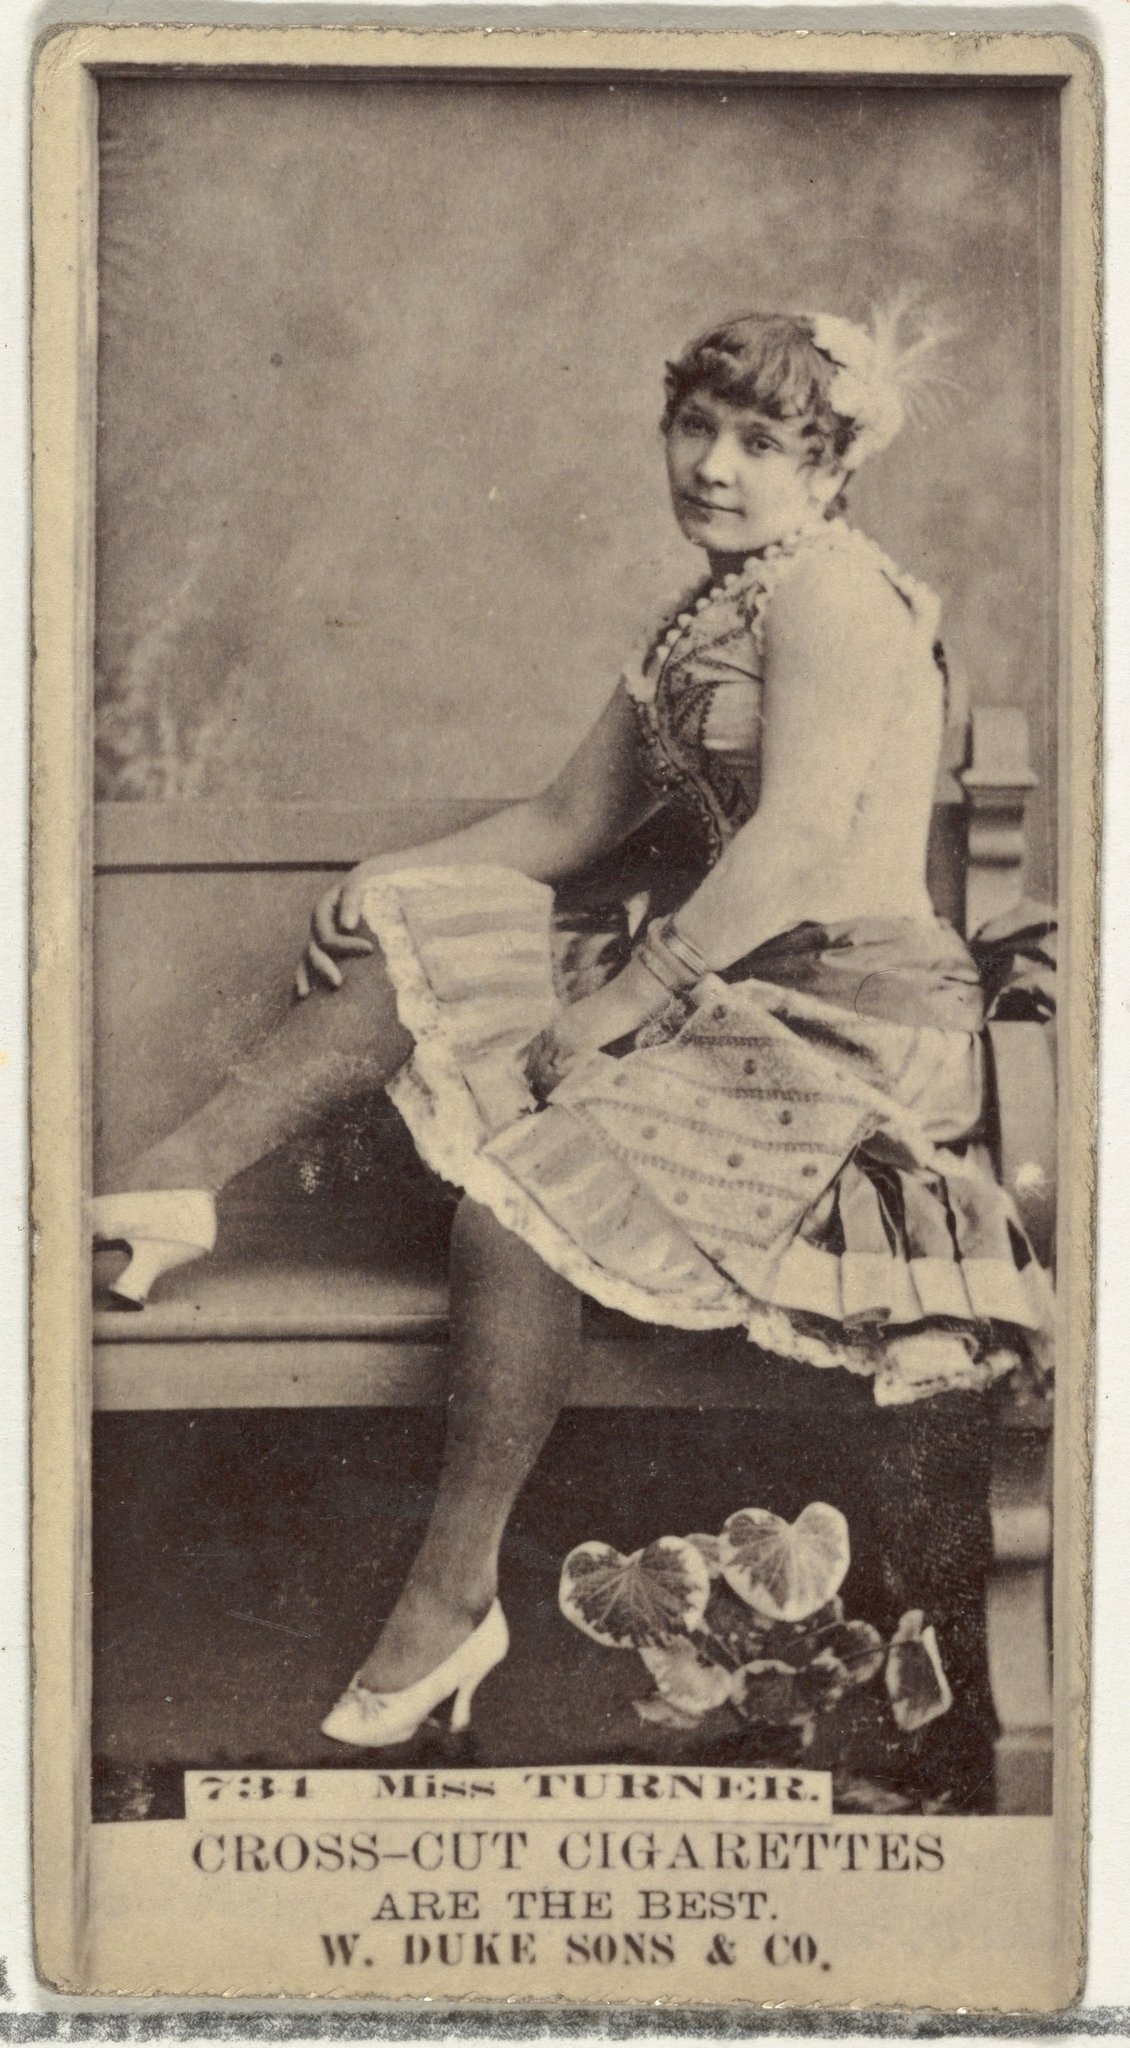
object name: photograph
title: Card Number 731, Miss Turner, from the Actors and Actresses series (N145-3) issued by Duke Sons & Co. to promote Cross Cut Cigarettes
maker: w. duke, sons & co.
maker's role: publisher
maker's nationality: american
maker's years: 1870-1920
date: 1880-1889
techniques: albumen silver print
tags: portraits,women,actresses